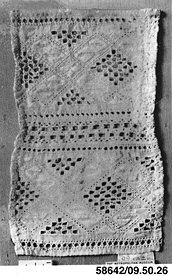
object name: fragment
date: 1801-1900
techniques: embroidery